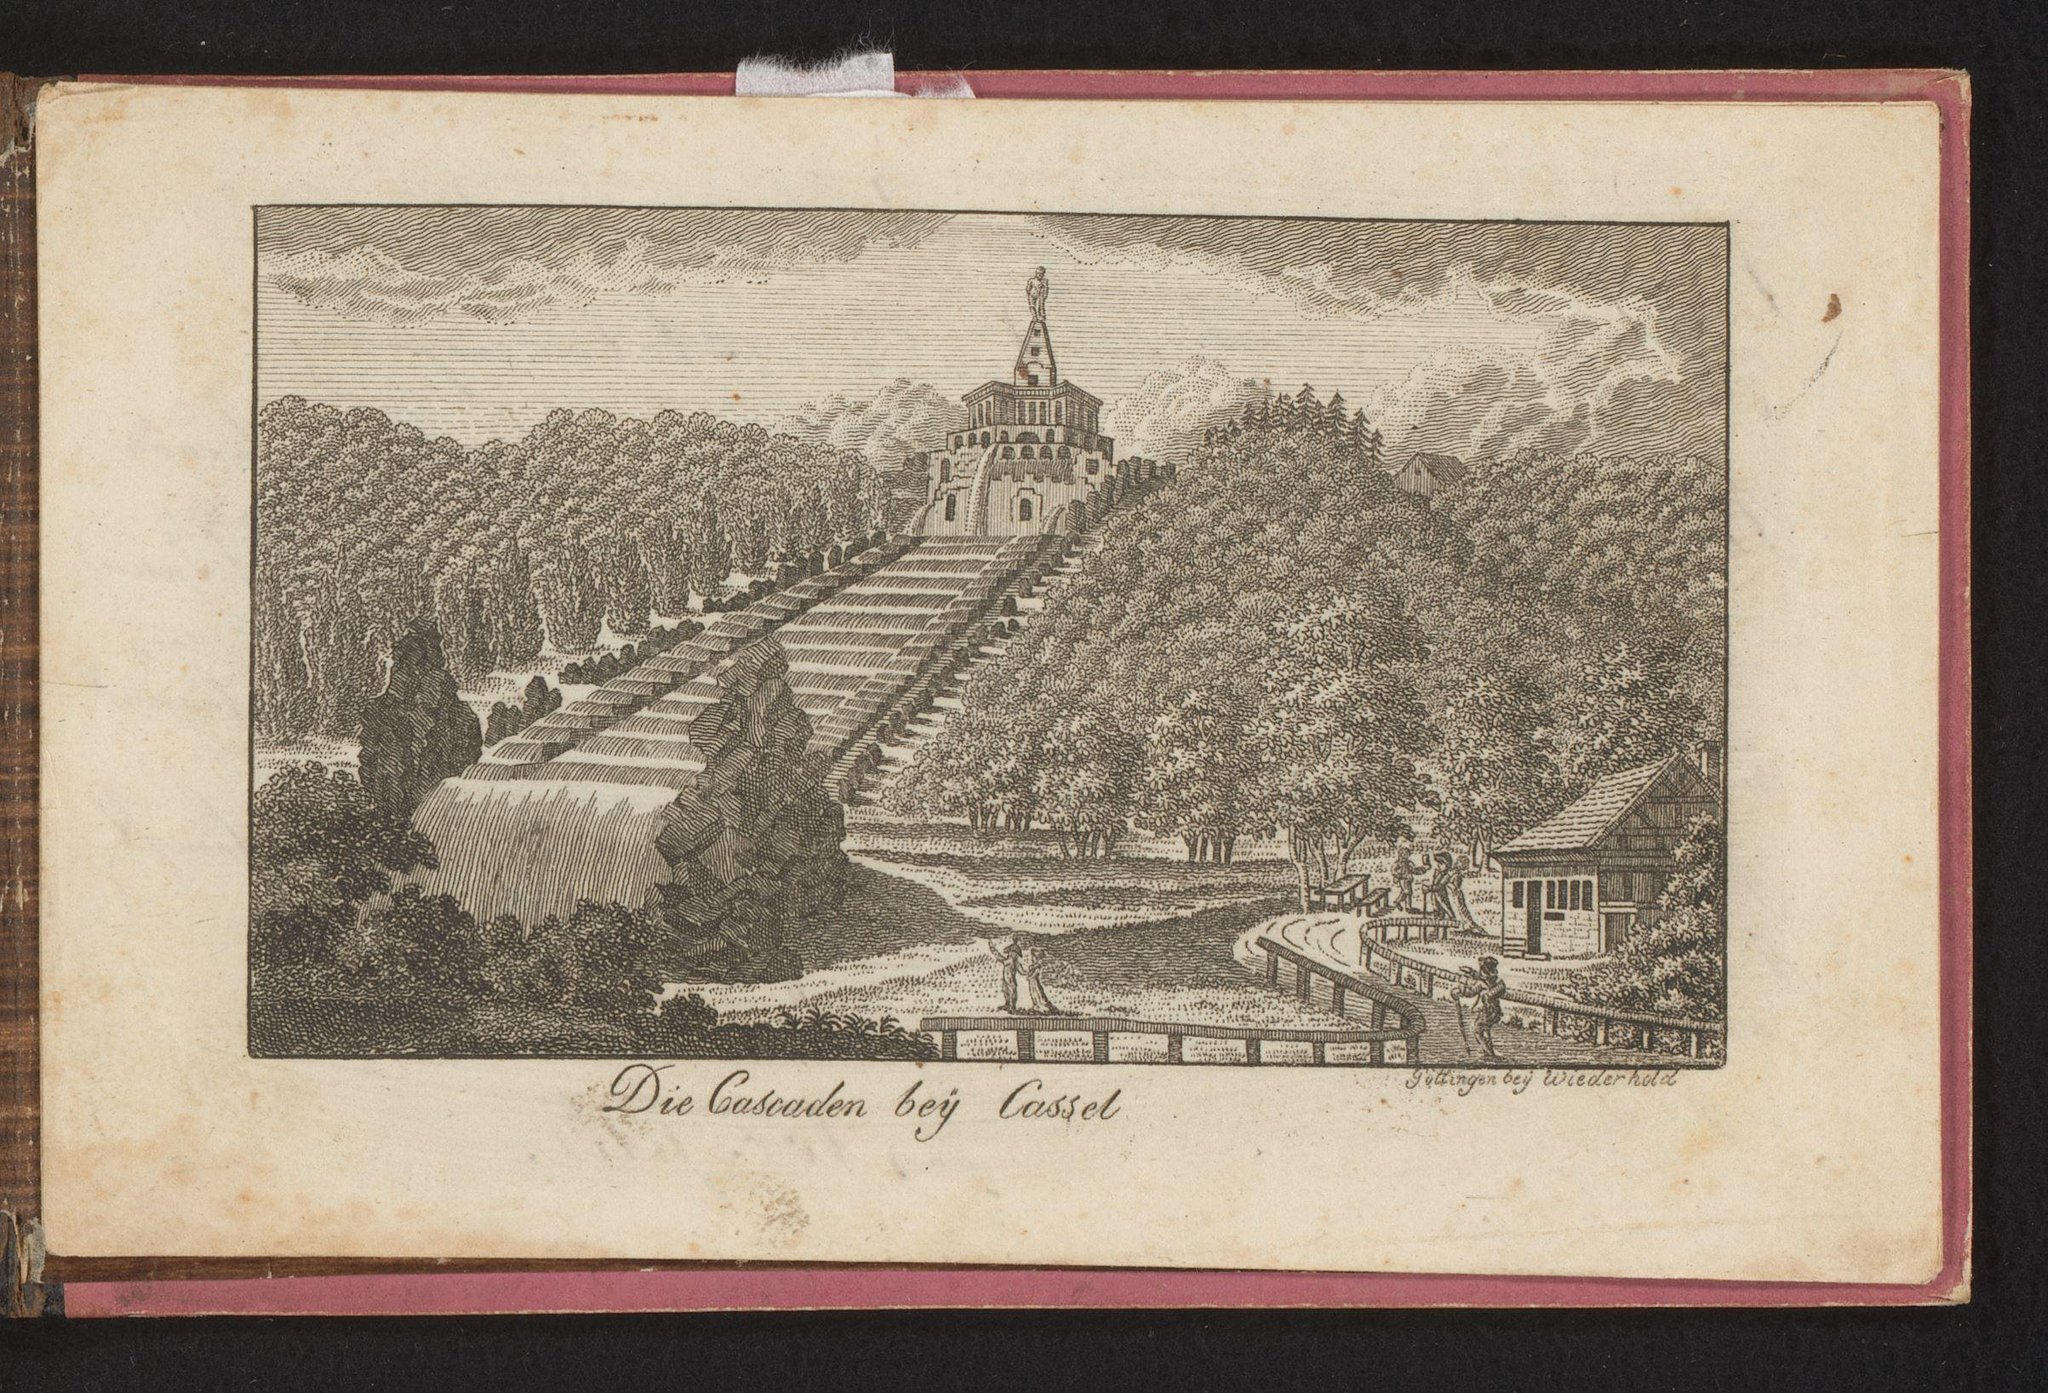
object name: print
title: Gezicht op het Hercules monument in het Bergpark Wilhelmshöhe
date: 1770-1826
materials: ink, paper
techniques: etching, writing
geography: gottingen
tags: 'album amicorum', 'stammbuch', landscape with monument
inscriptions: tekst, verso, handgeschreven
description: Handgeschreven tekst in het Duits op het verso.